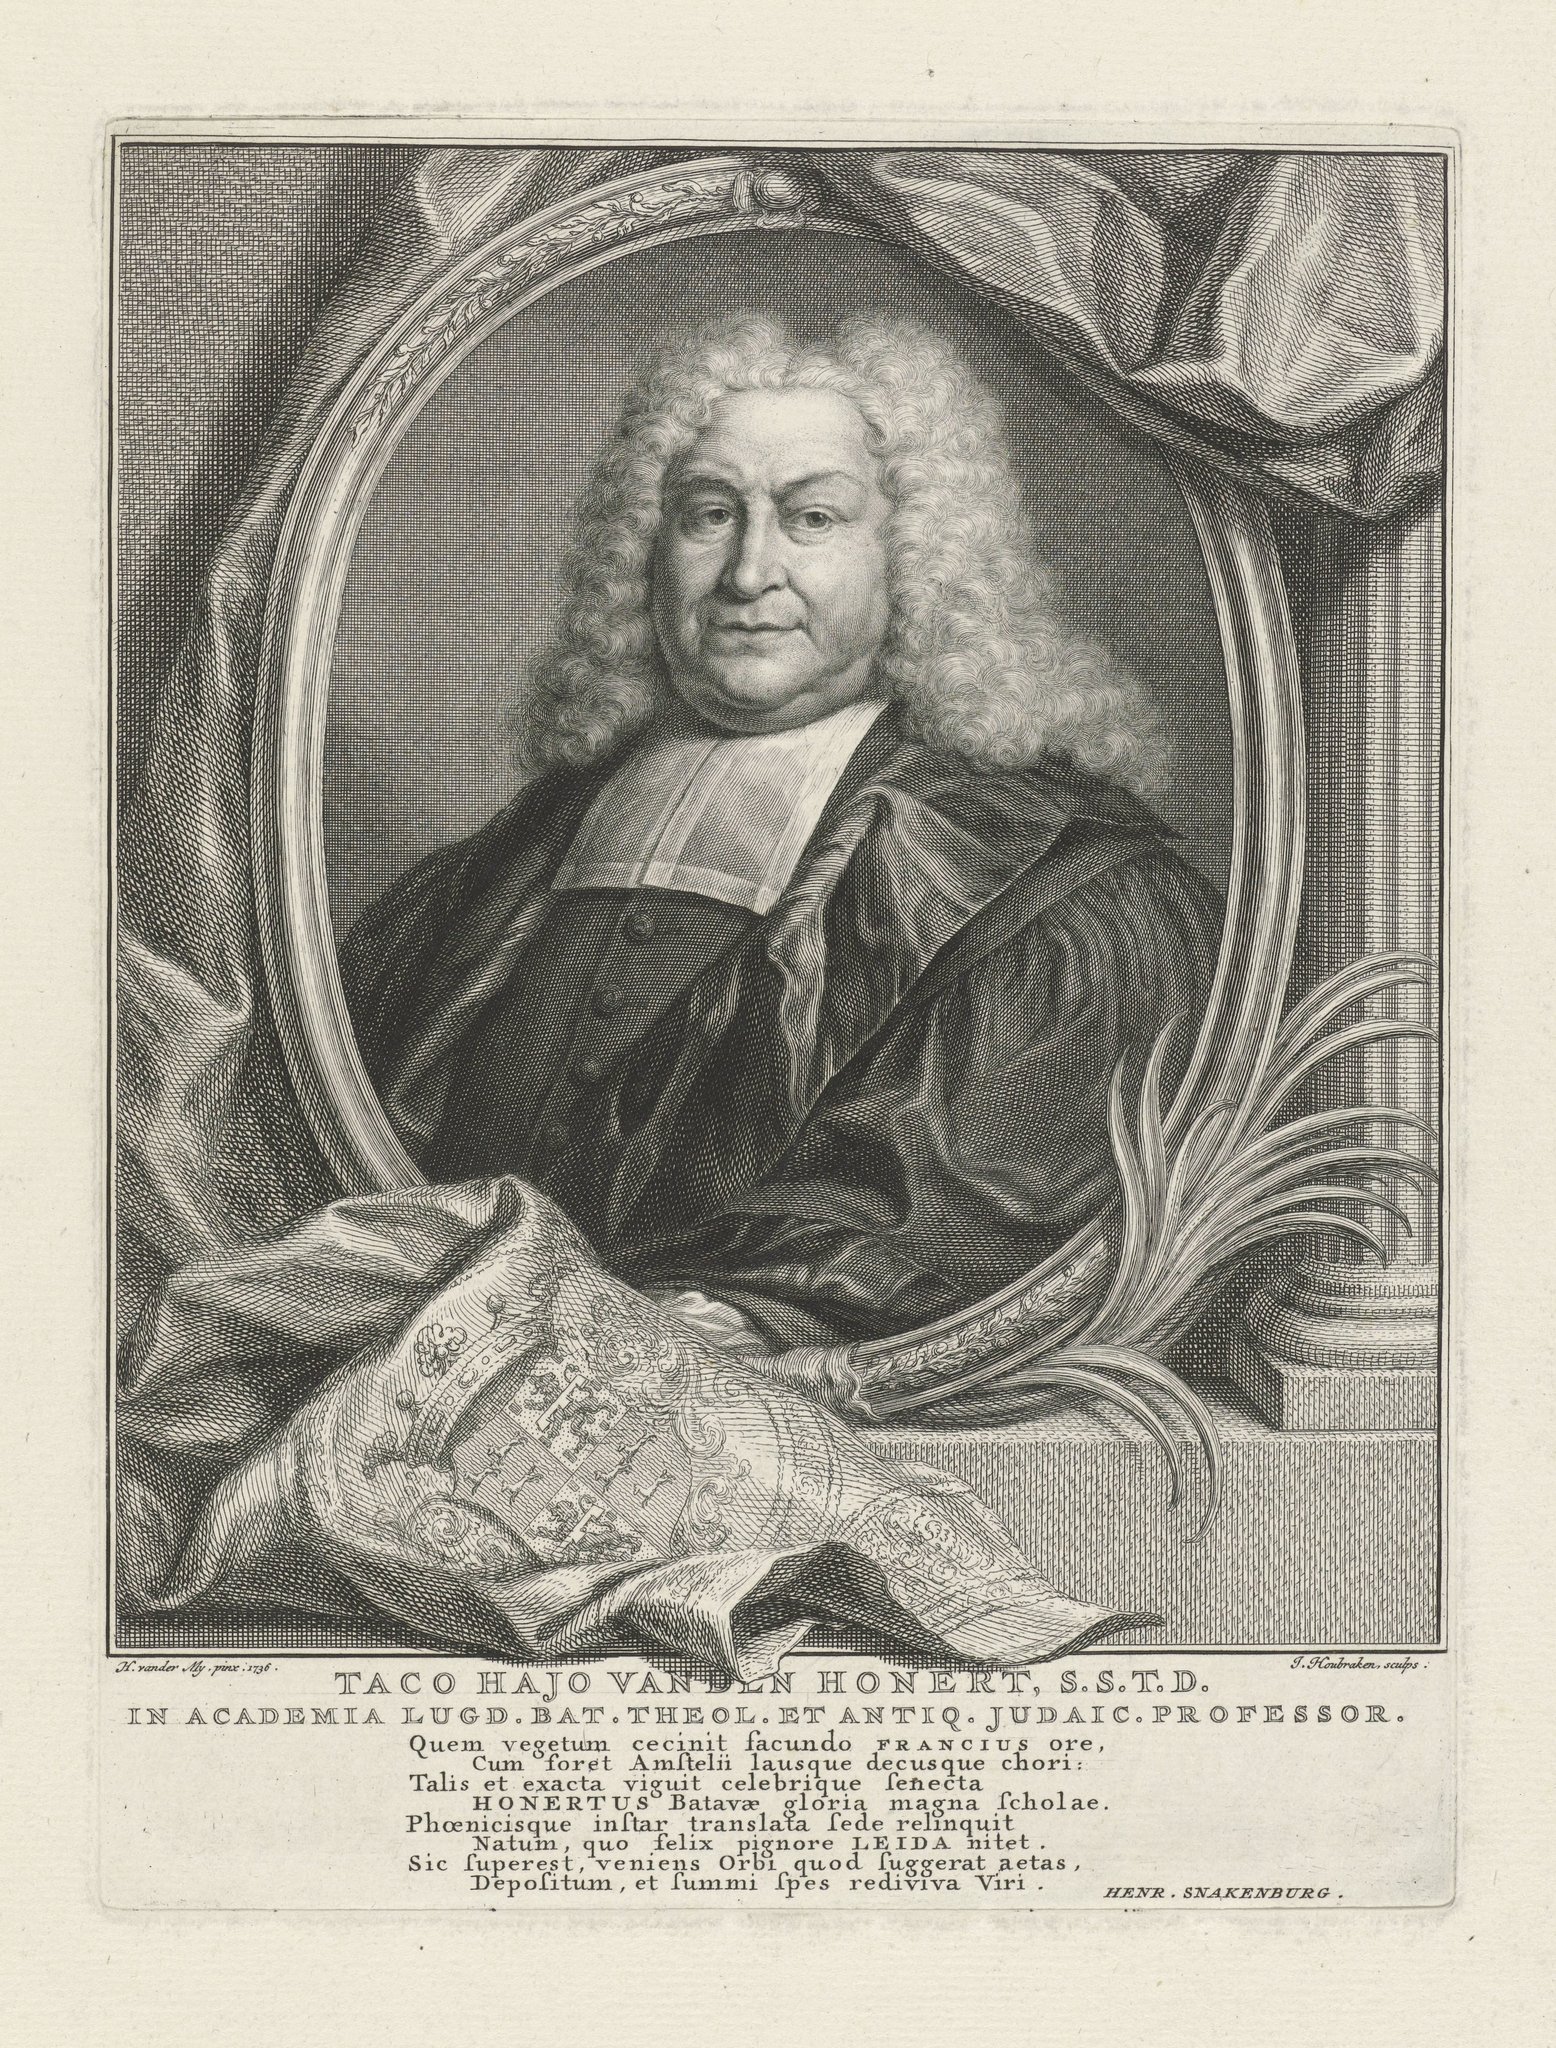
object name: print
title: Portret van Taco Hajo van den Honert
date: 1736-1755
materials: paper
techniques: engraving, etching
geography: amsterdam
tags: leiden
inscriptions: collector's mark: Lugt 240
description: Buste naar links van Taco Hajo van den Honert in een ovaal medaillon. Rond het portret een draperie met zijn familiewapen. Het portret rust op een plint waarop rechts een zuil. Onder het portret zijn naam in twee regels in het Latijn en daaronder acht regels in het Latijn.